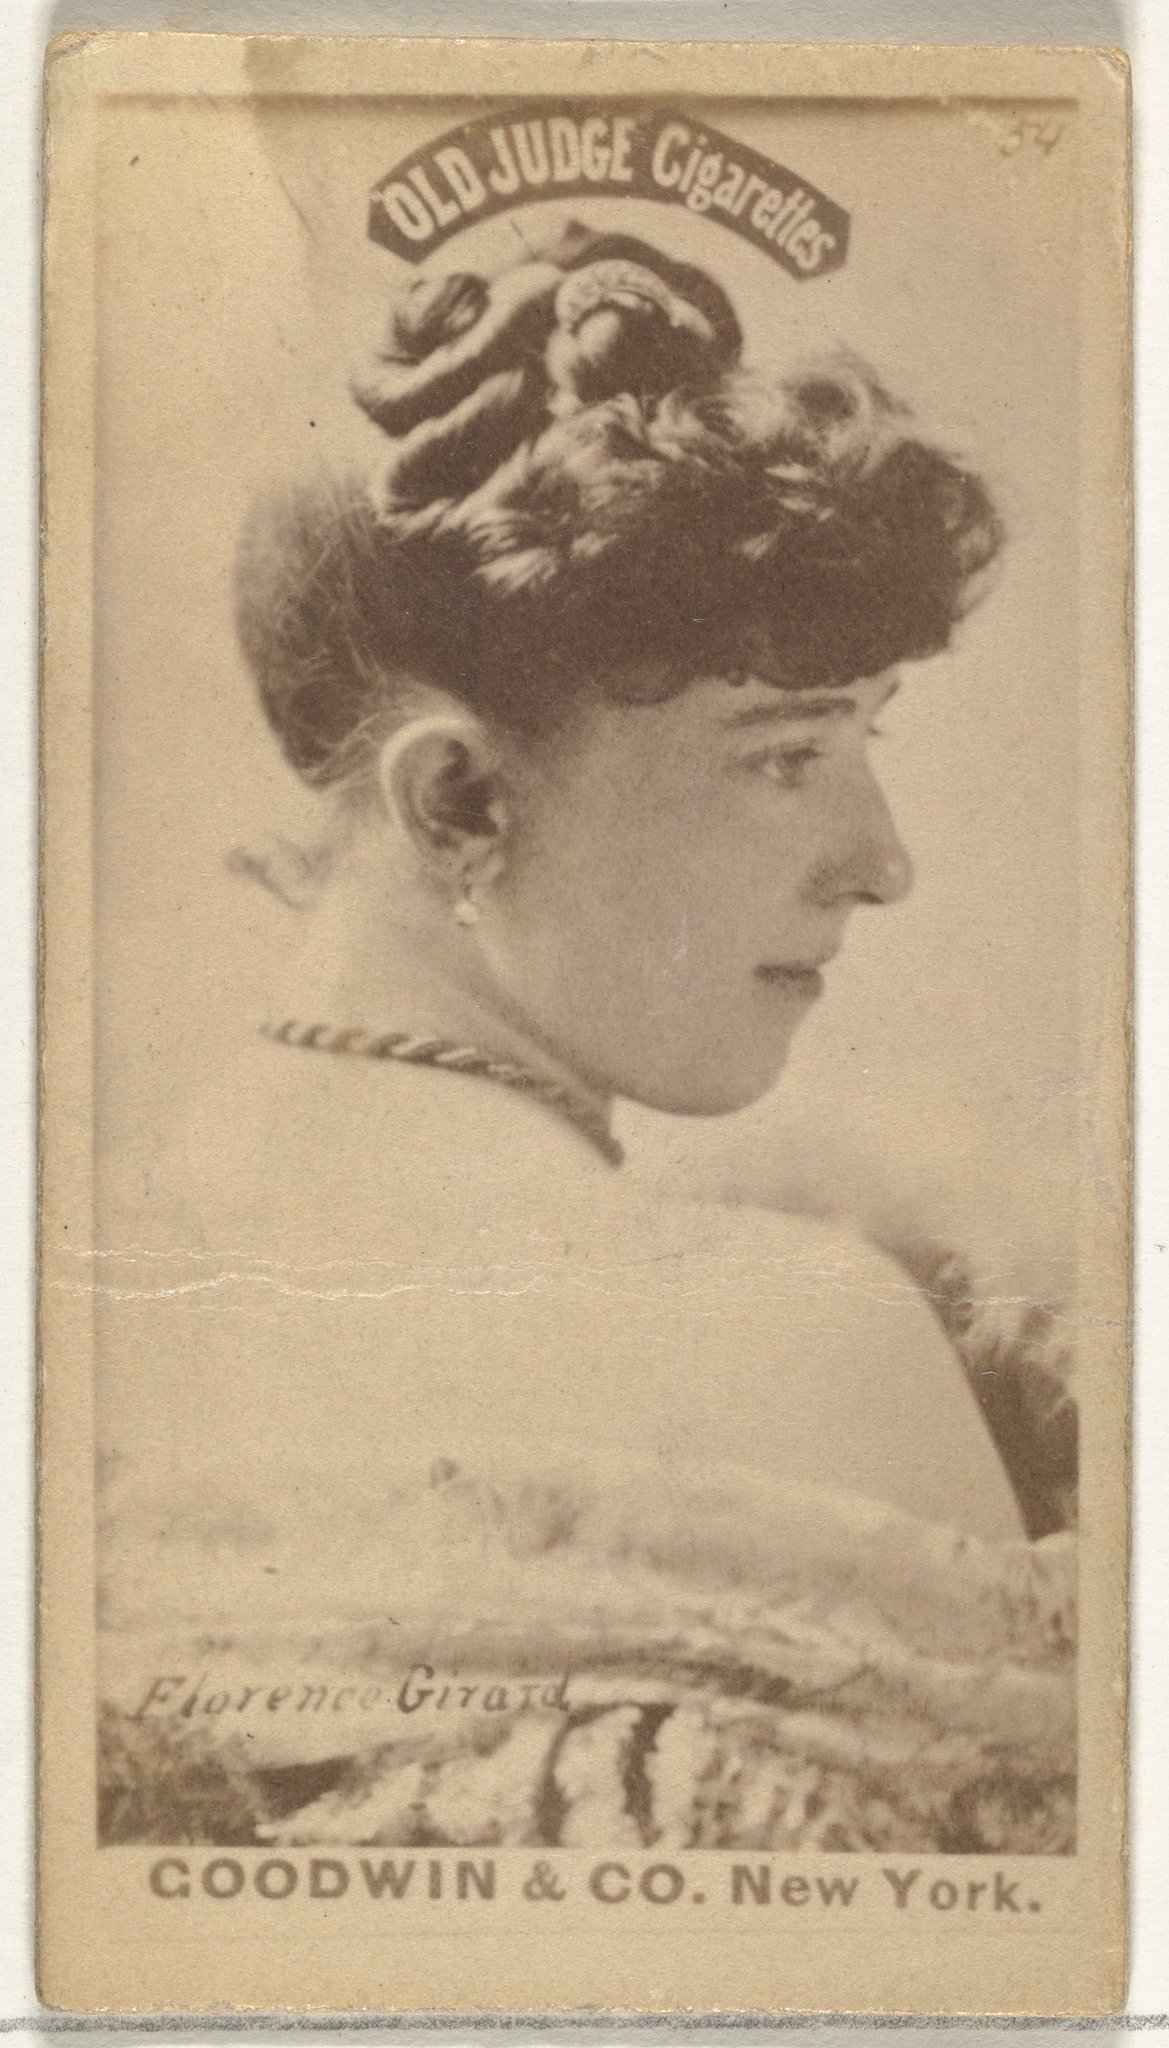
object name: photograph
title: Florence Girard, from the Actors and Actresses series (N171) for Old Judge Cigarettes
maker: goodwin & company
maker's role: publisher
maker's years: 1850-1950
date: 1886-1890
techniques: albumen silver print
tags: portraits,women,actresses